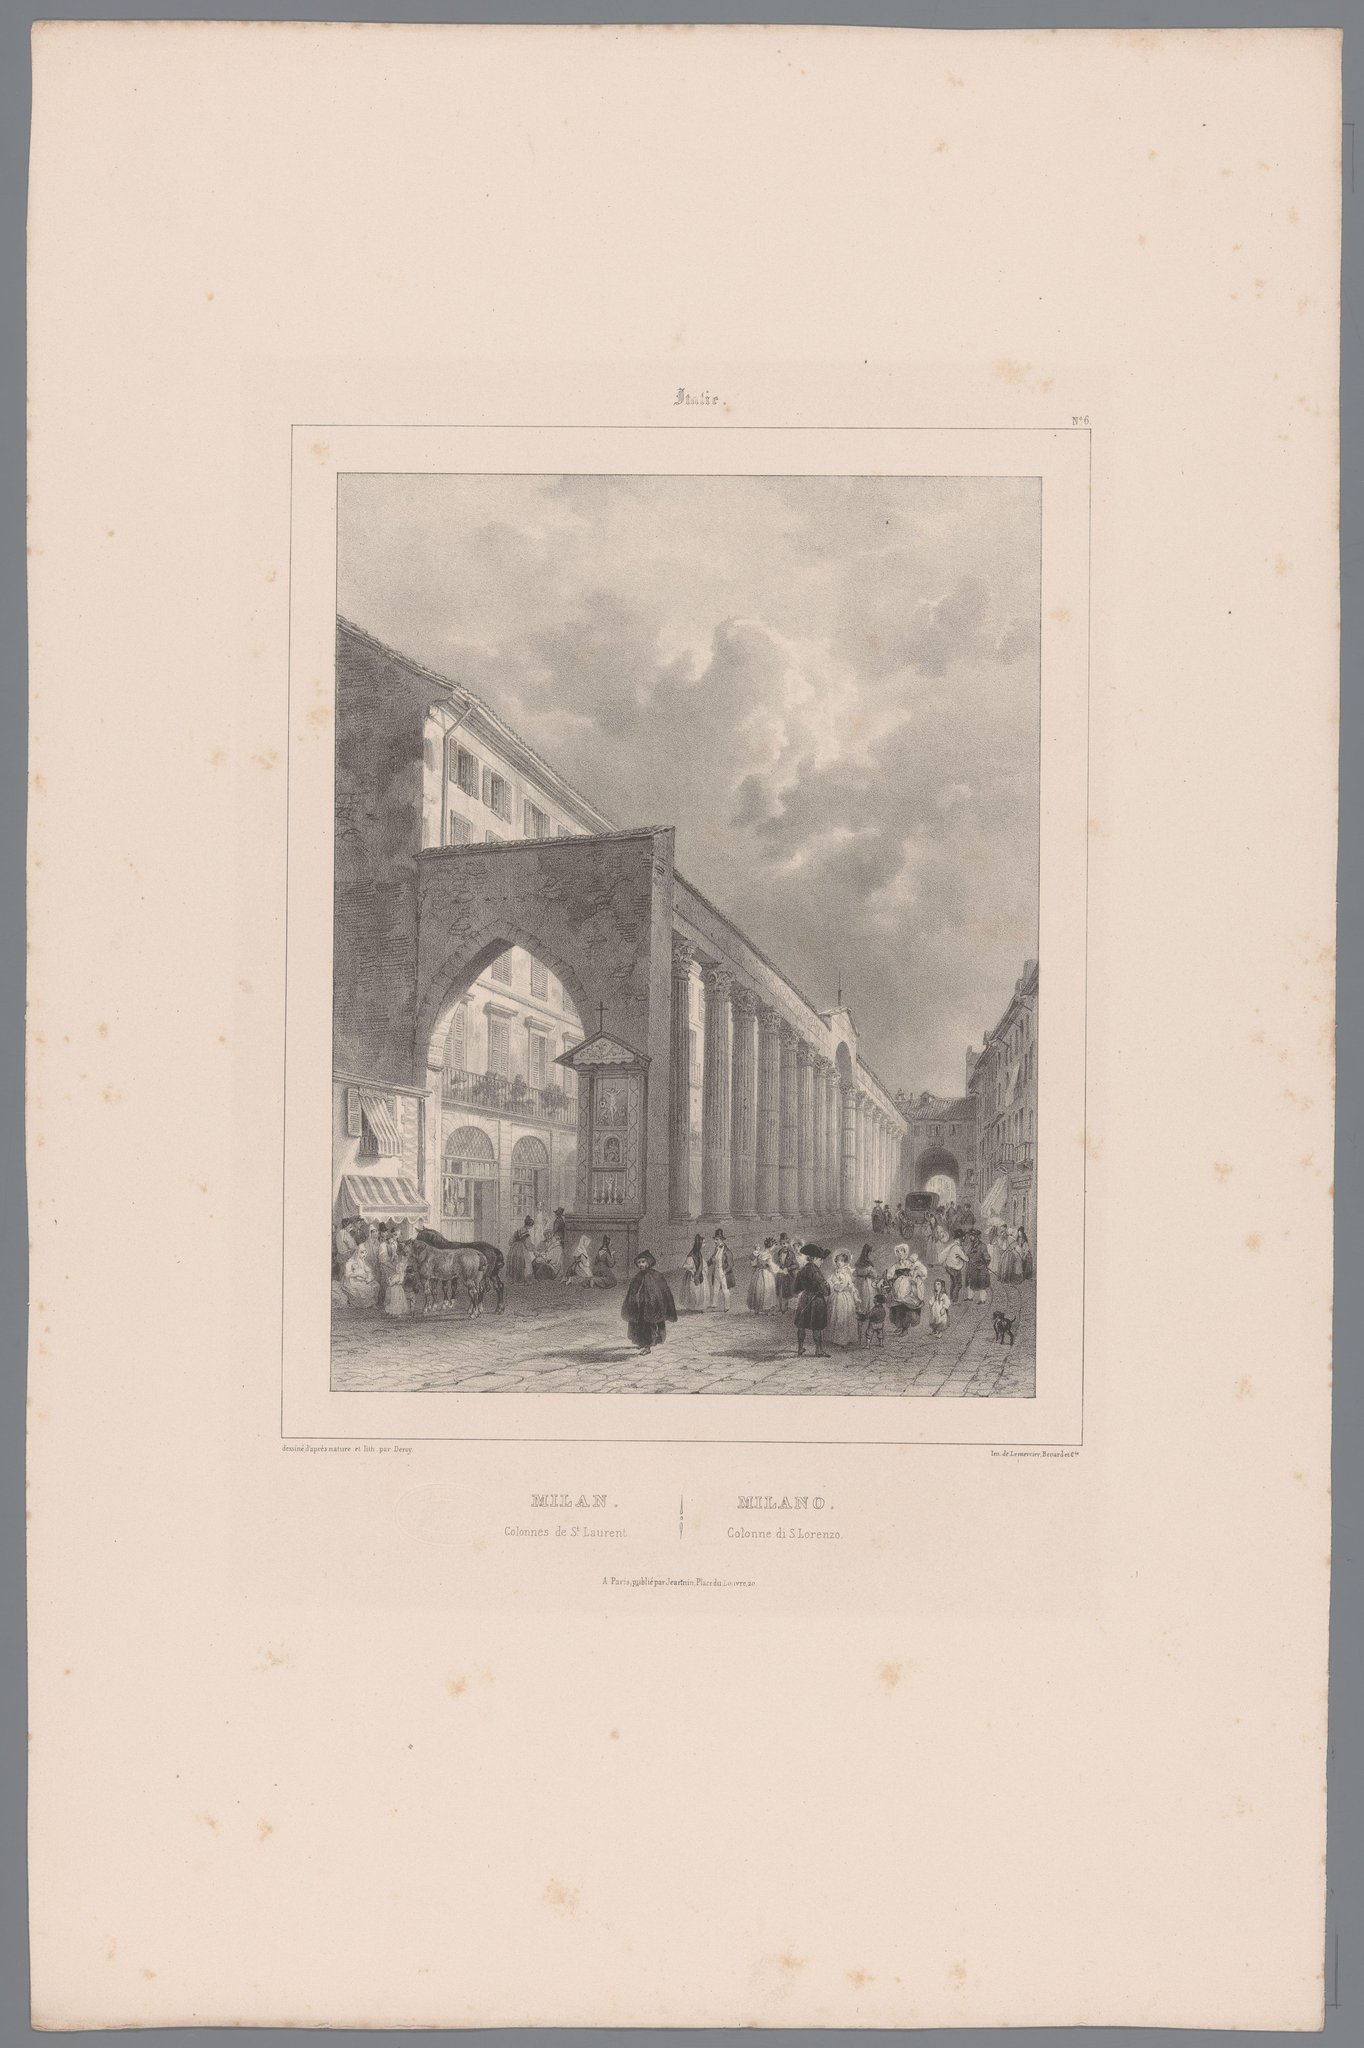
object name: print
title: Gezichten in Milaan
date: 1838-1841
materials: paper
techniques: lithograph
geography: paris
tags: colonnade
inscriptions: collector's mark: Lugt 2228a, check stamp: Lugt 1397c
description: Prent maakt deel uit van een omslag met zes prenten.